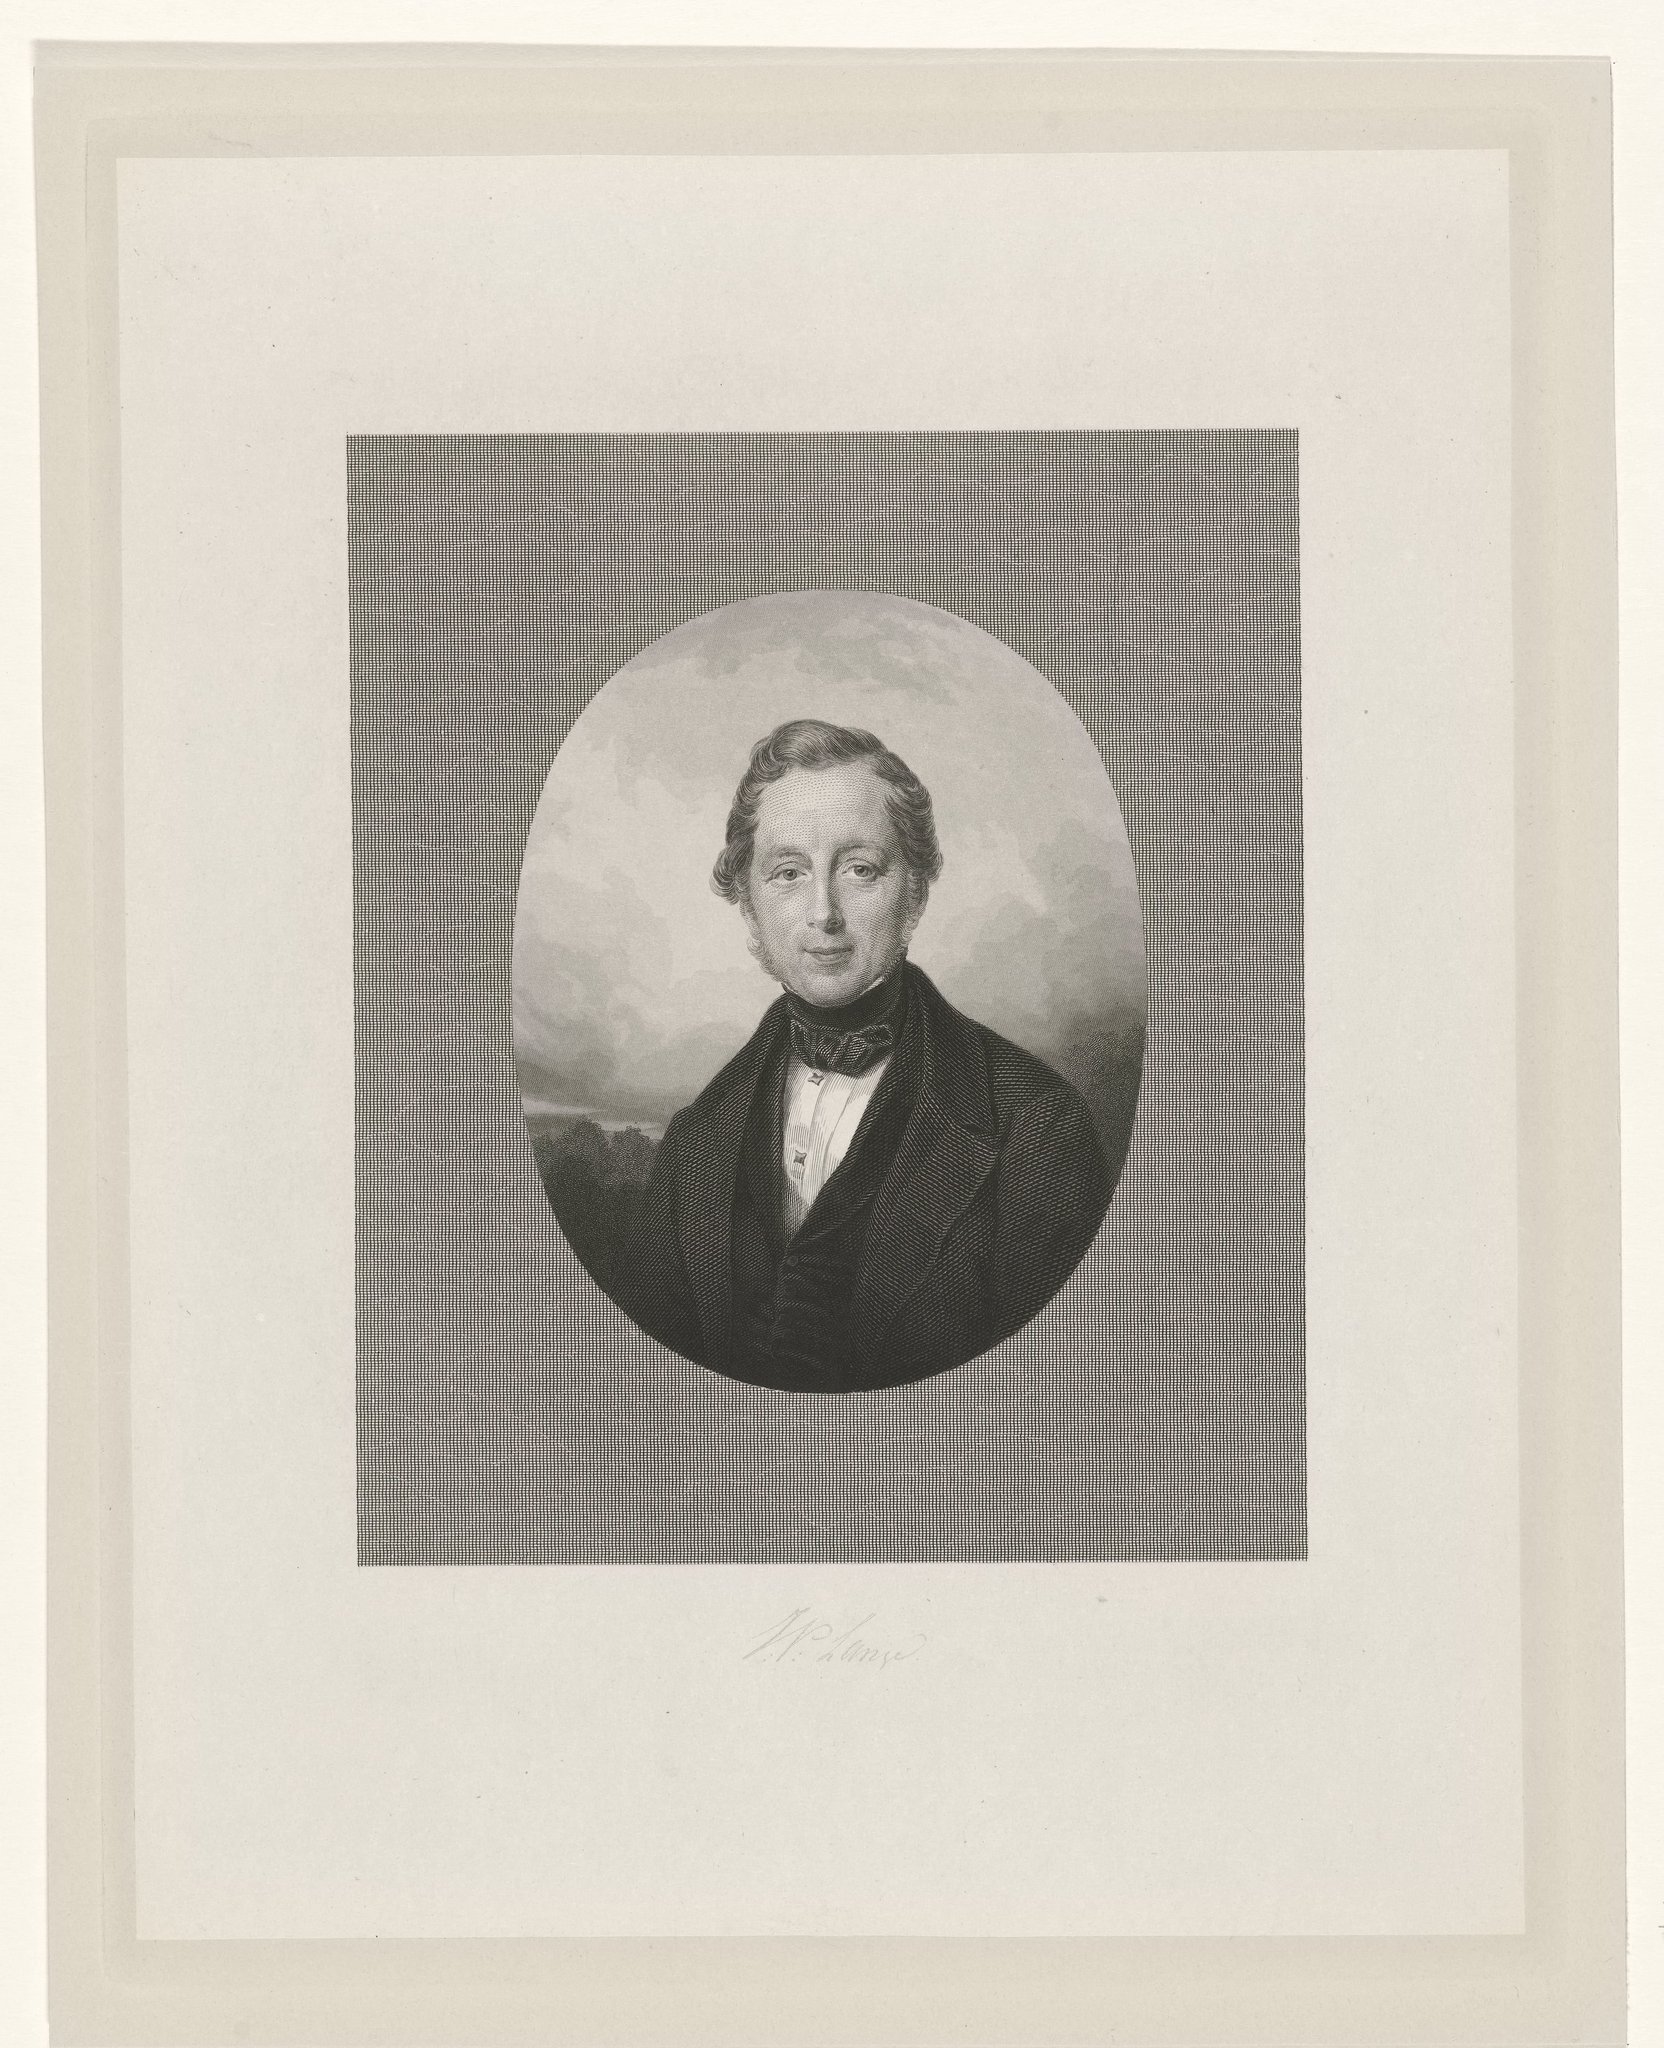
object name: print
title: Portret van Krieger Schumer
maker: johannes philippus lange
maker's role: print maker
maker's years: 1810-1849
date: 1820-1849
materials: paper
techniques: engraving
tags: krieger schumer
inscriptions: collector's mark: Lugt 12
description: Portretbuste in ovaal naar links van Krieger Schumer, arts te Amsterdam.